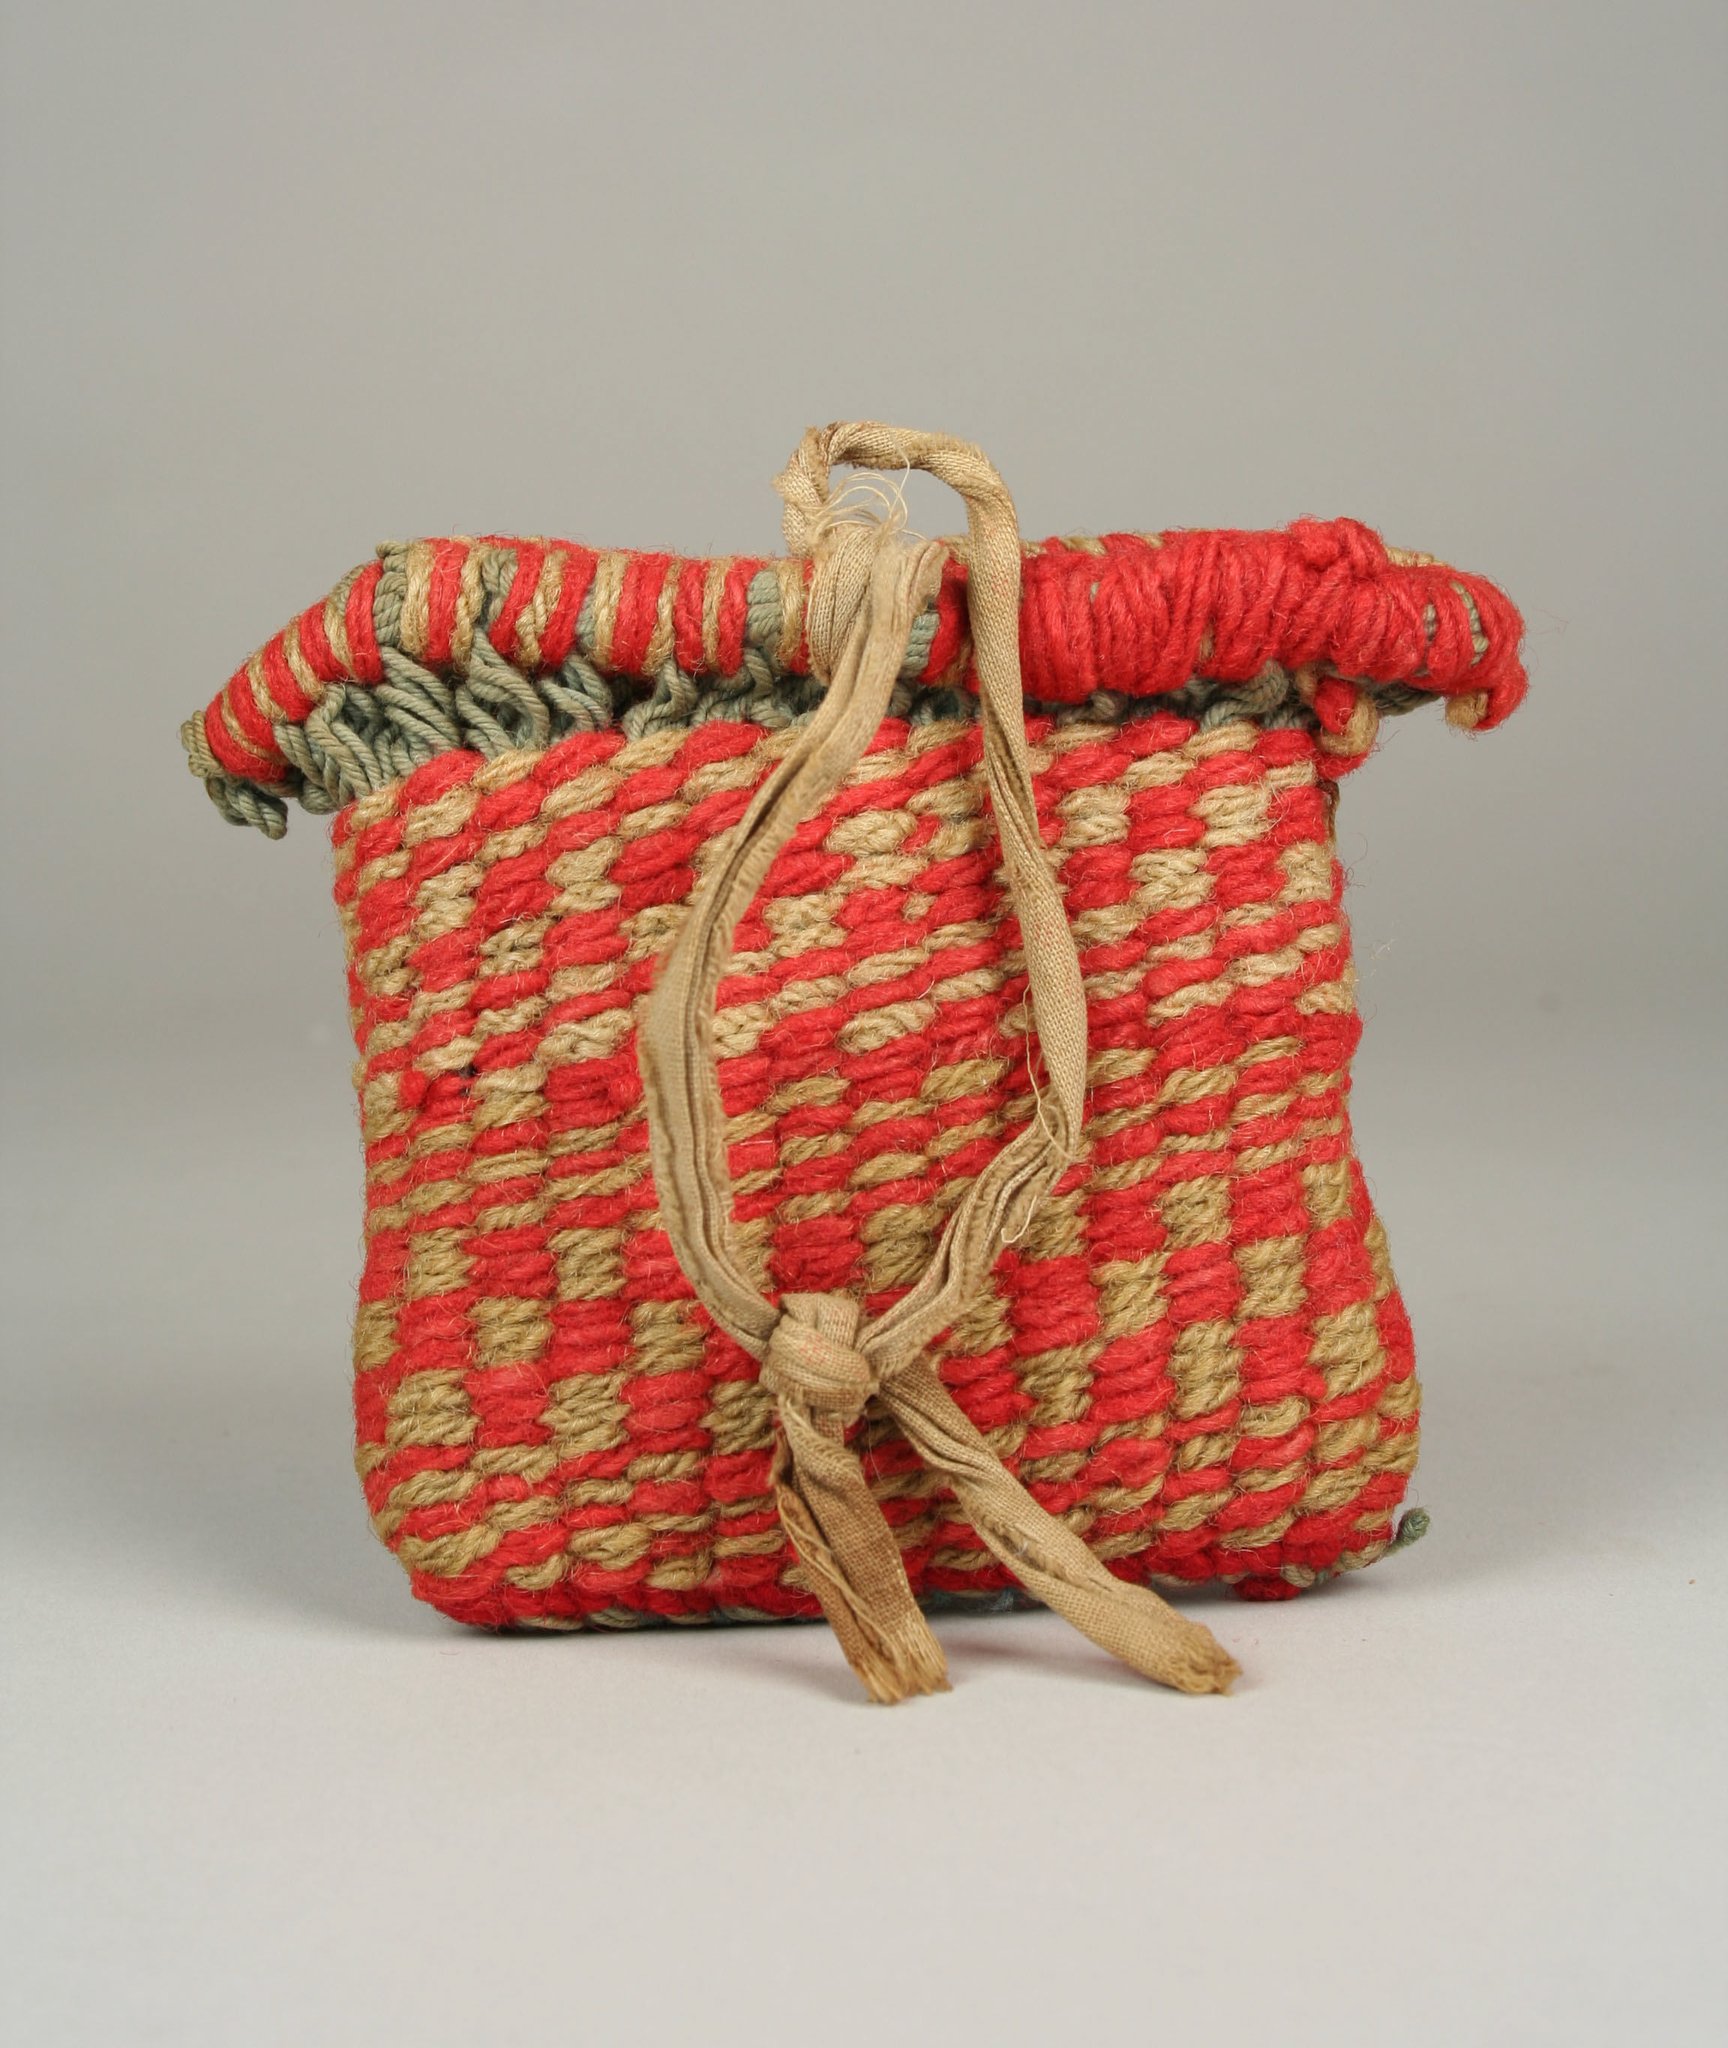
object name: charm bag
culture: mesquakie or potawatomi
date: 1790-1890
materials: wool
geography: united states